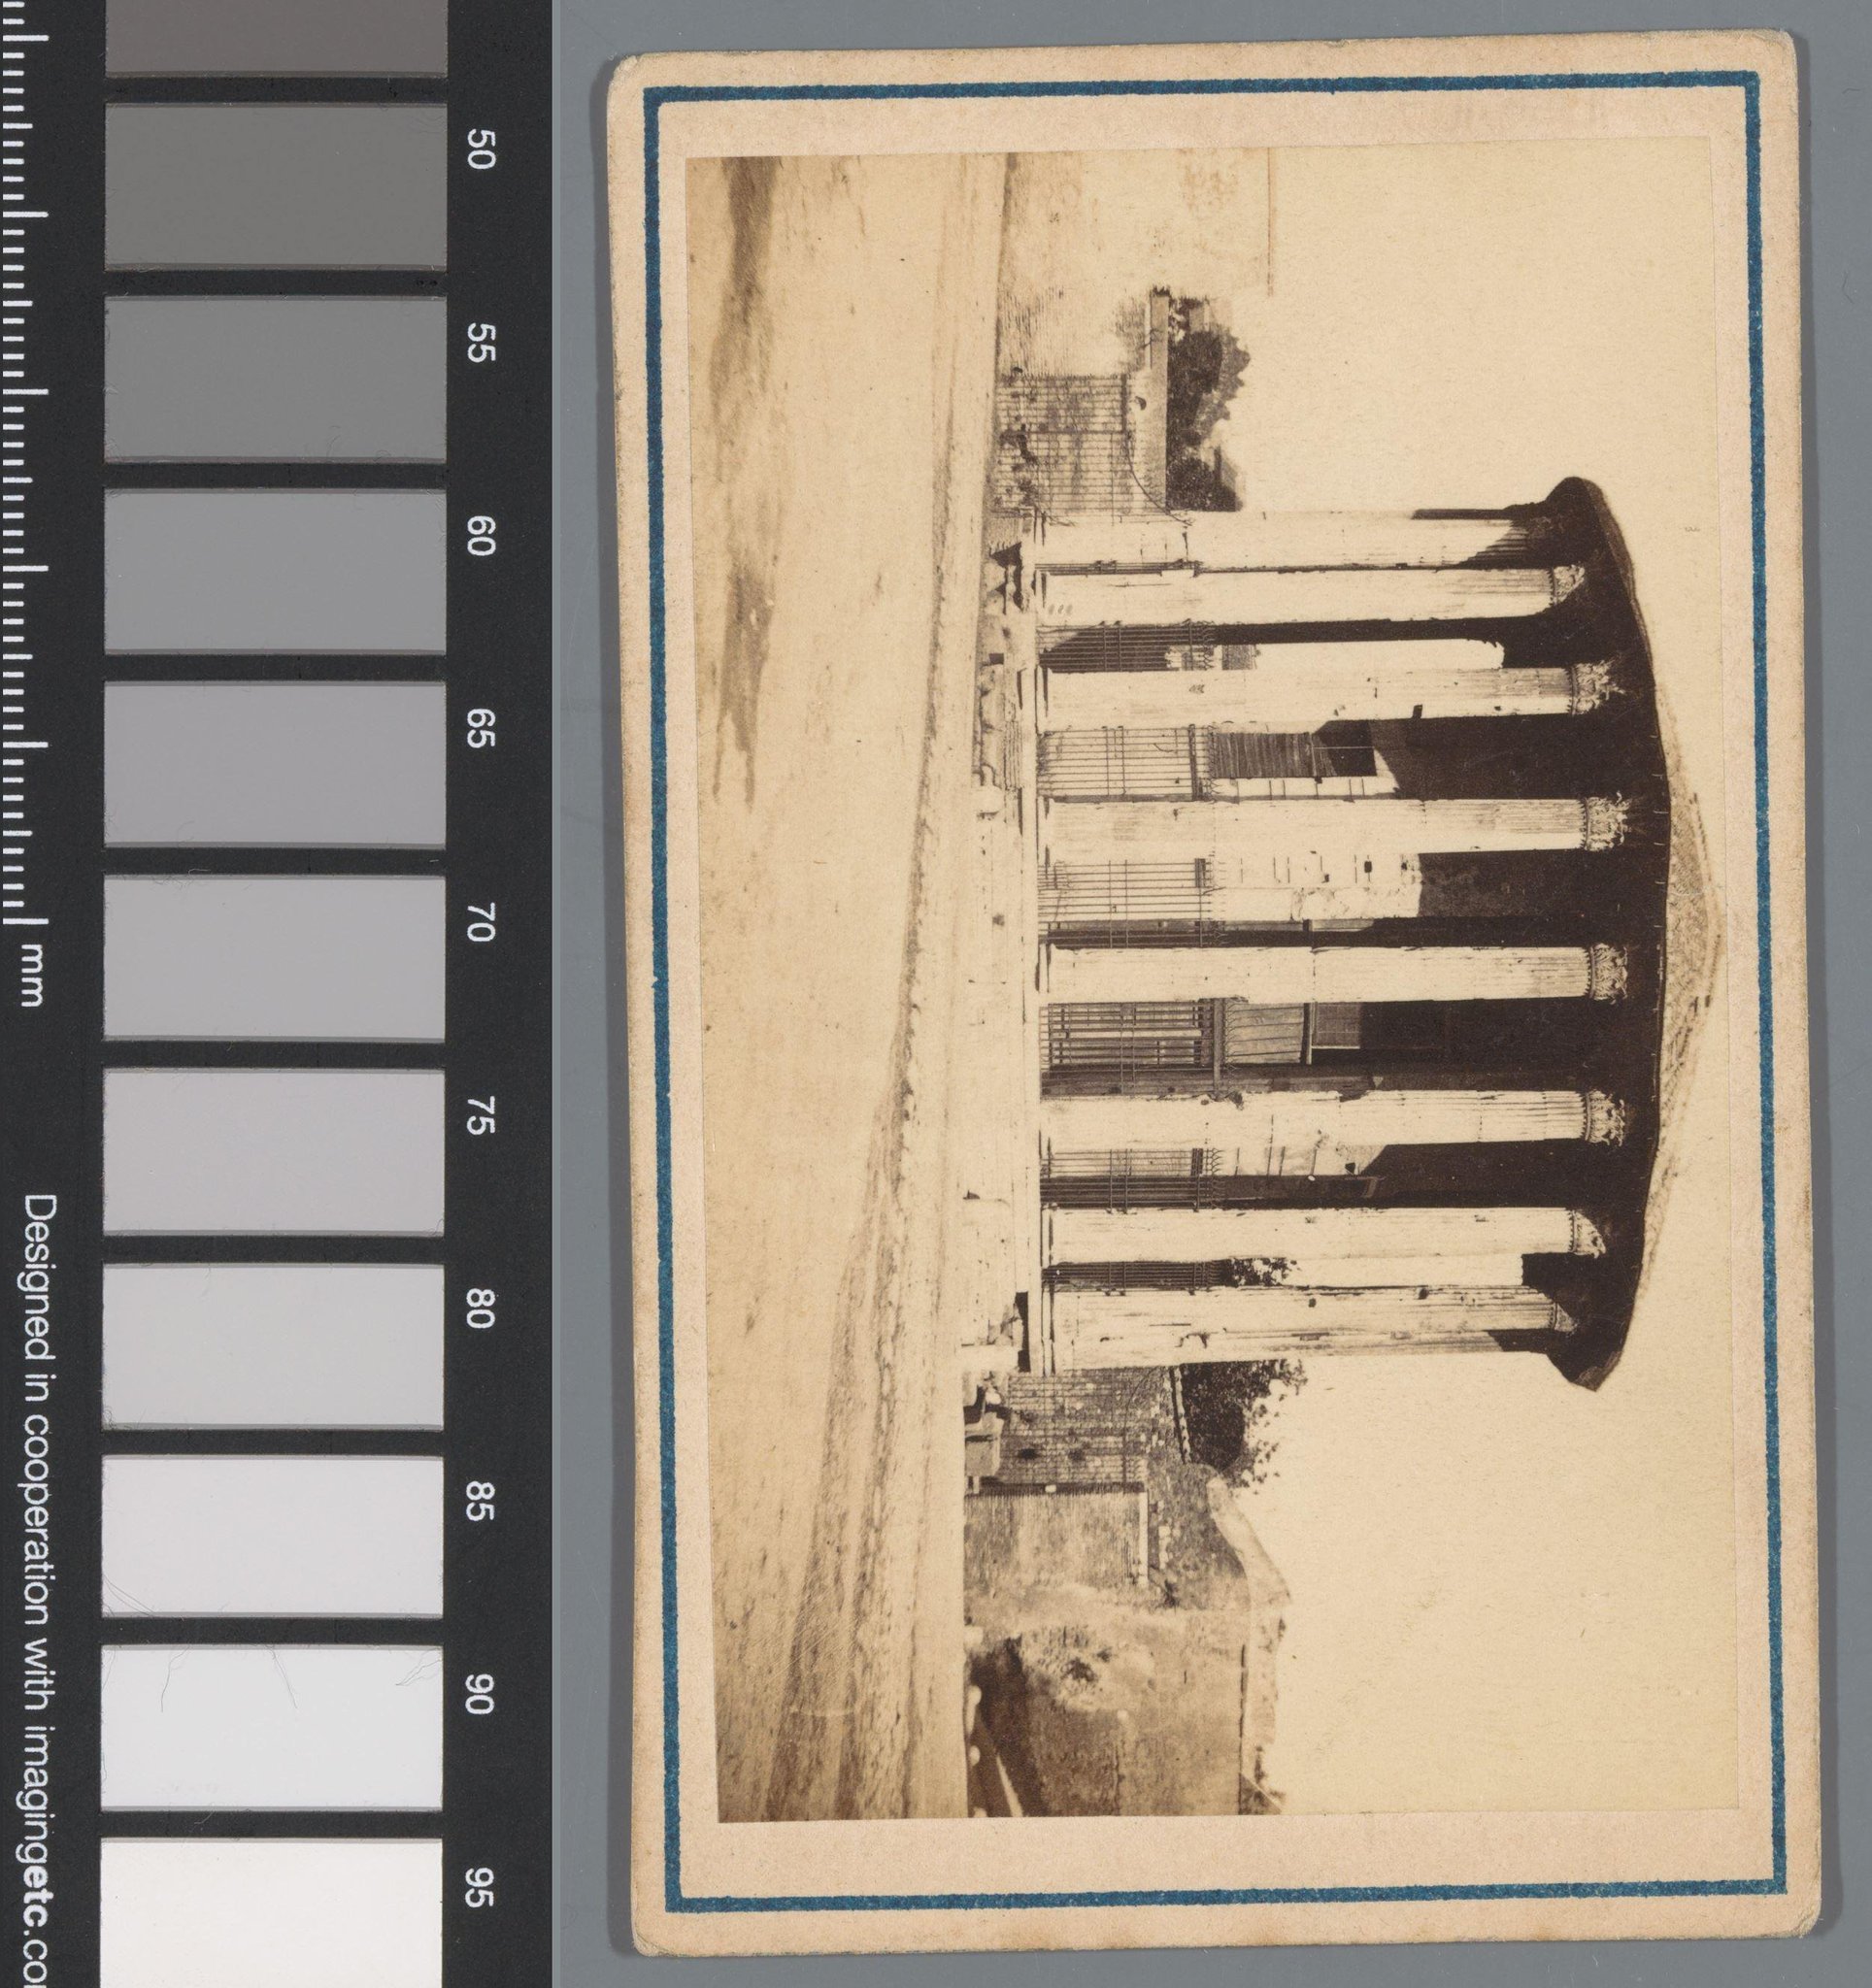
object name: carte de visite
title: Tempel van Hercules Invictus, Rome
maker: Anonymous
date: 1855-1885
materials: cardboard, paper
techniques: albumen print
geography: rome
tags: temple, shrine ~ roman religion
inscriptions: inscription: ‘TEmple de Neta (Rome)’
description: De Tempel van Hercules Invictus wordt vaak ten onrechte voor de Tempel van Vesta aangezien.